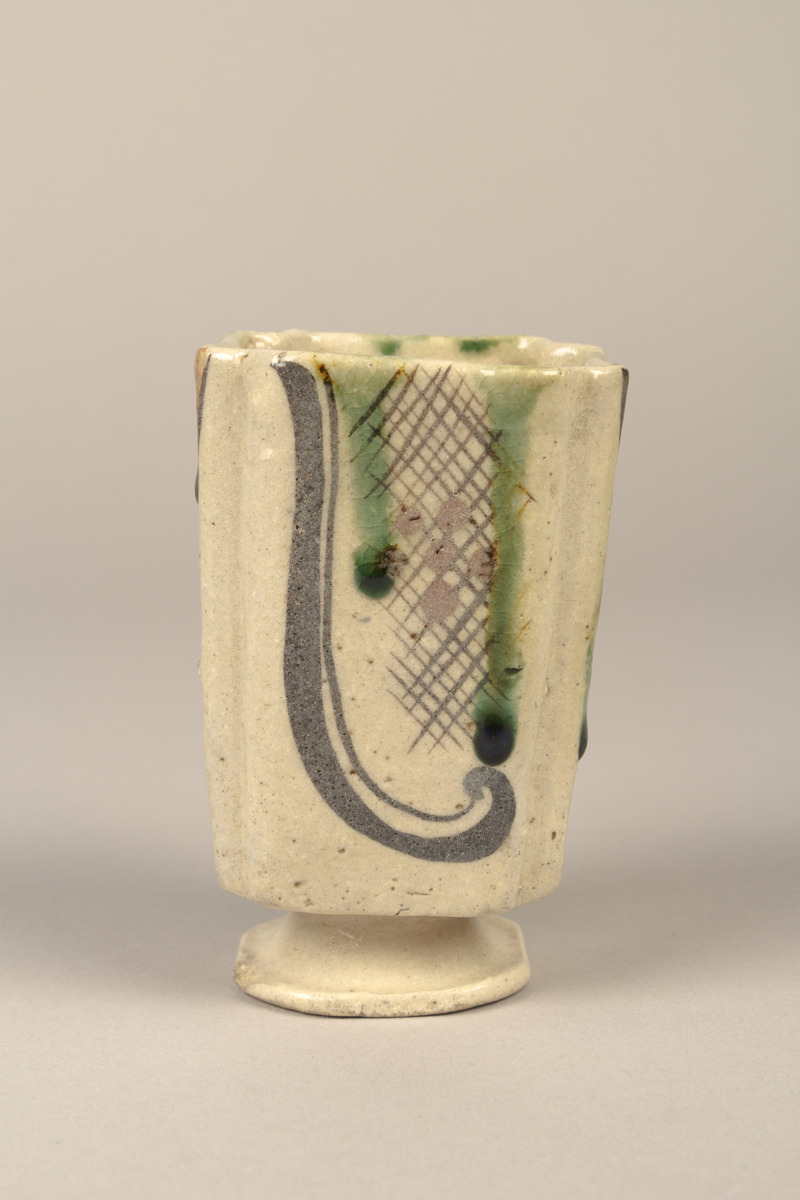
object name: food vessel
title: One from set of five squared food vessels (mukōzuke) for tea-gathering meal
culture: japanese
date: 1601-1633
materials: copper, iron, stoneware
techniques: overglaze